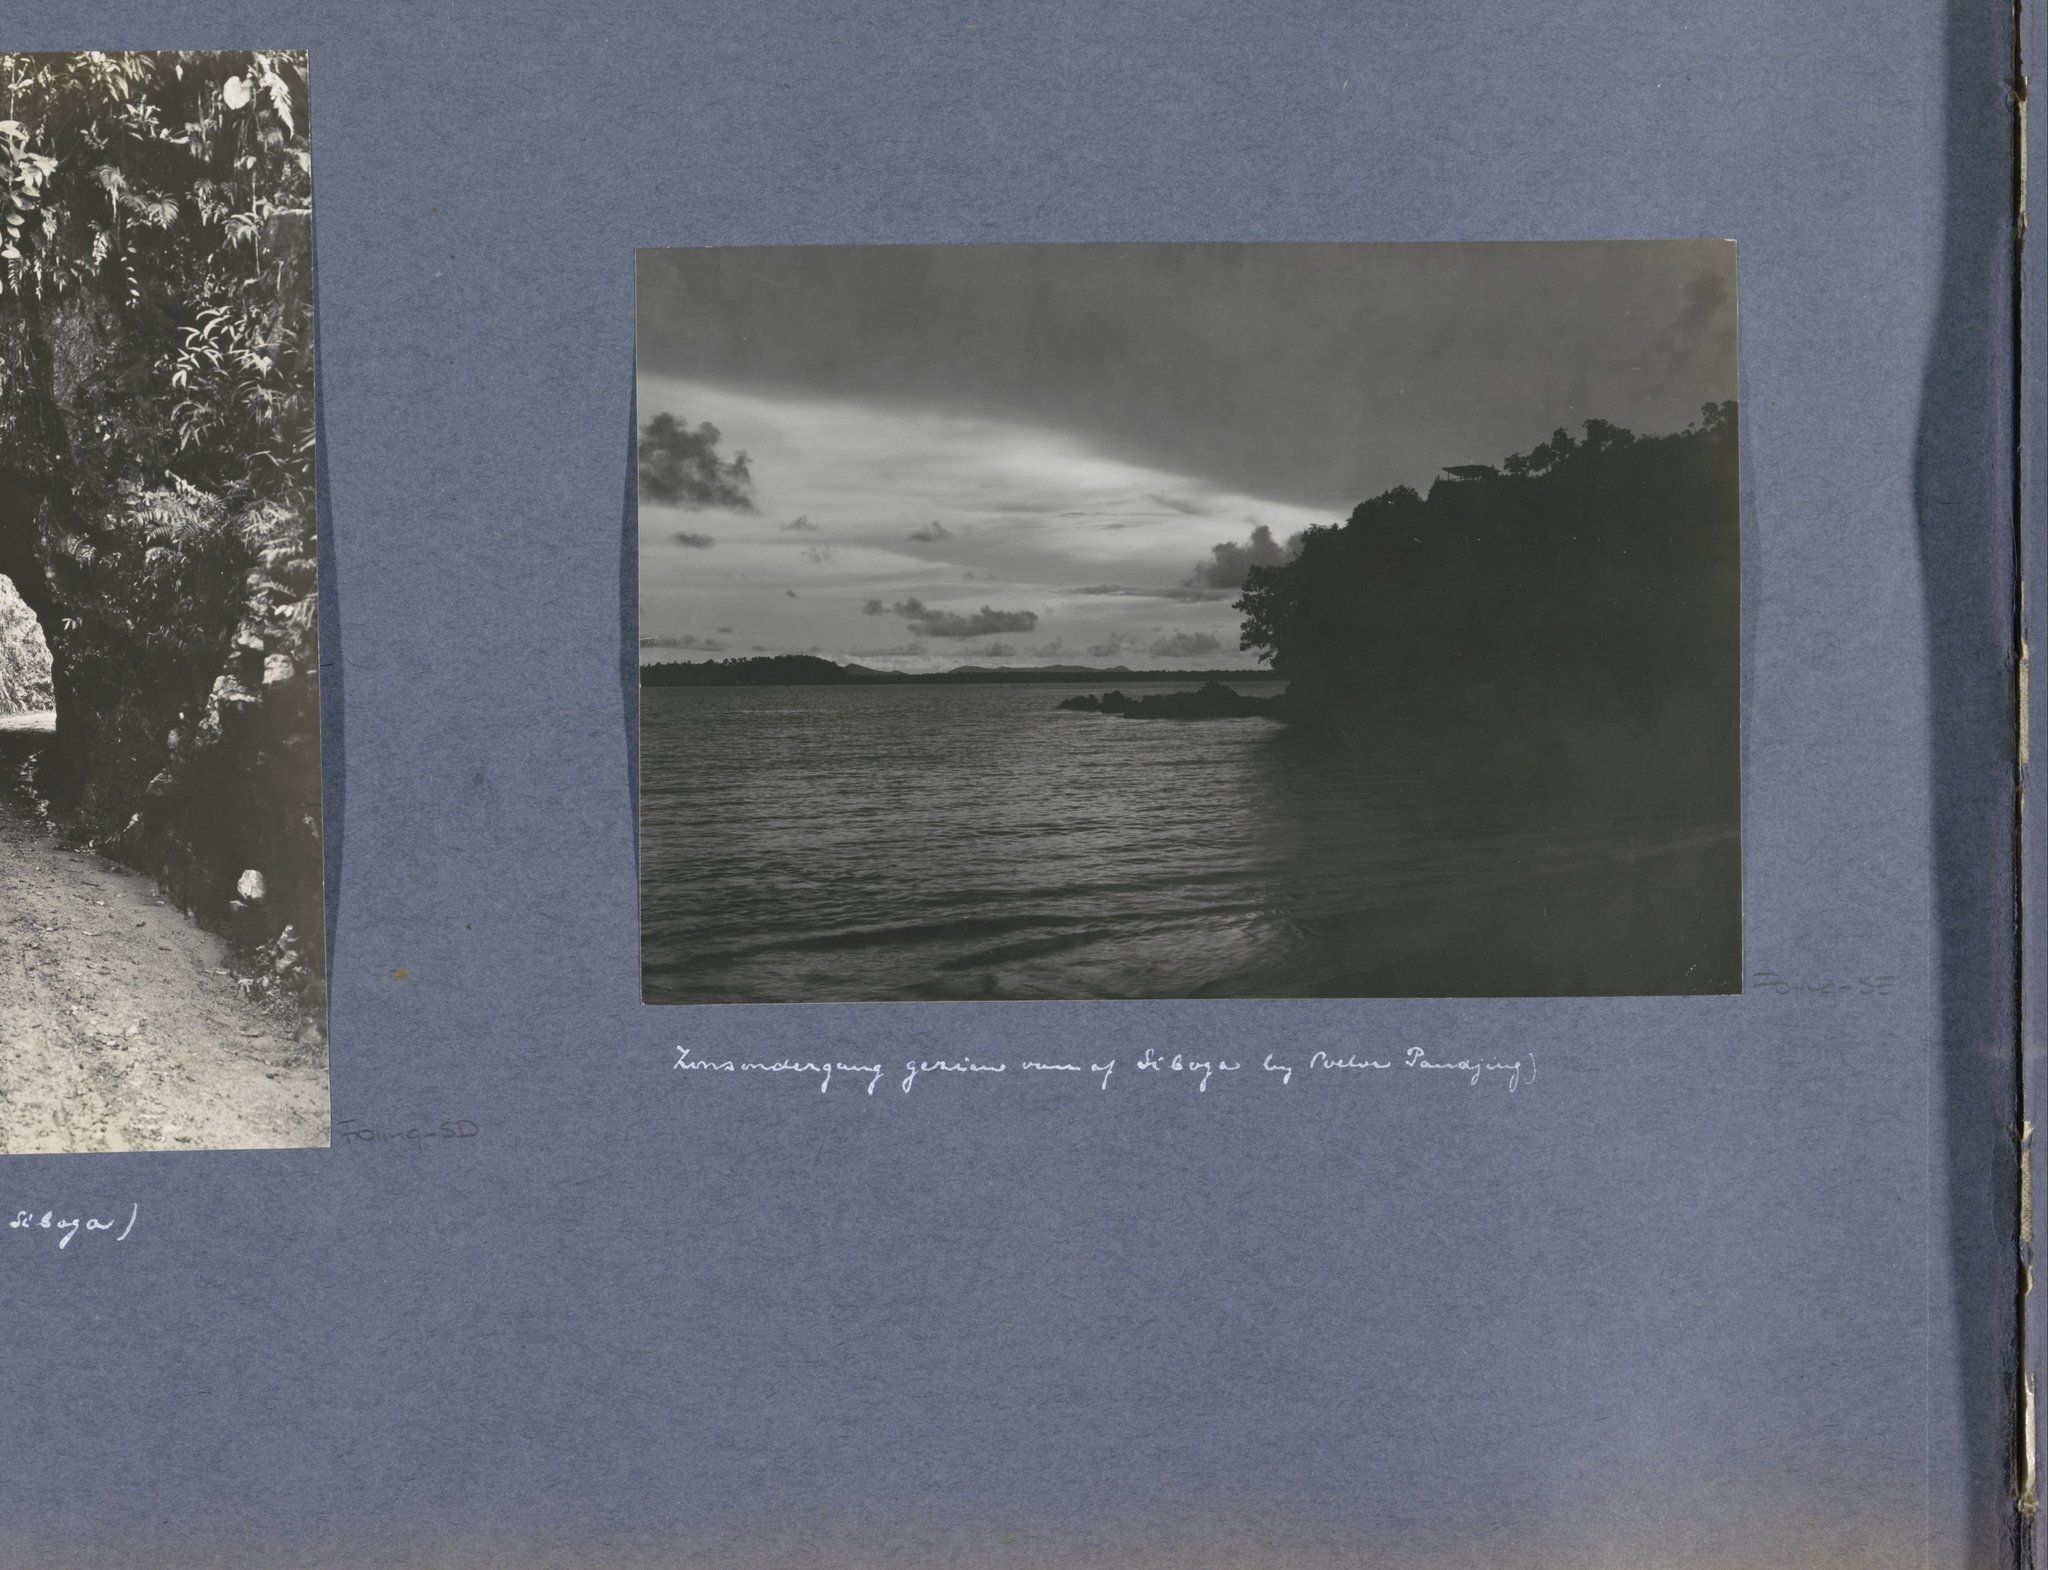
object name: photograph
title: Zonsondergang boven een water op Sumatra, gezien vanaf Siboga bij Poeloe Pandjang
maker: Anonymous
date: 1900-1920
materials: paper, photographic support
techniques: gelatin silver print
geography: sumatra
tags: sunset, sumatra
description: Onderdeel van reisalbum met foto's van bedrijvigheid en bezienswaardigheden op Sumatra en Java en van de reis naar en van Nederlands-Indië.